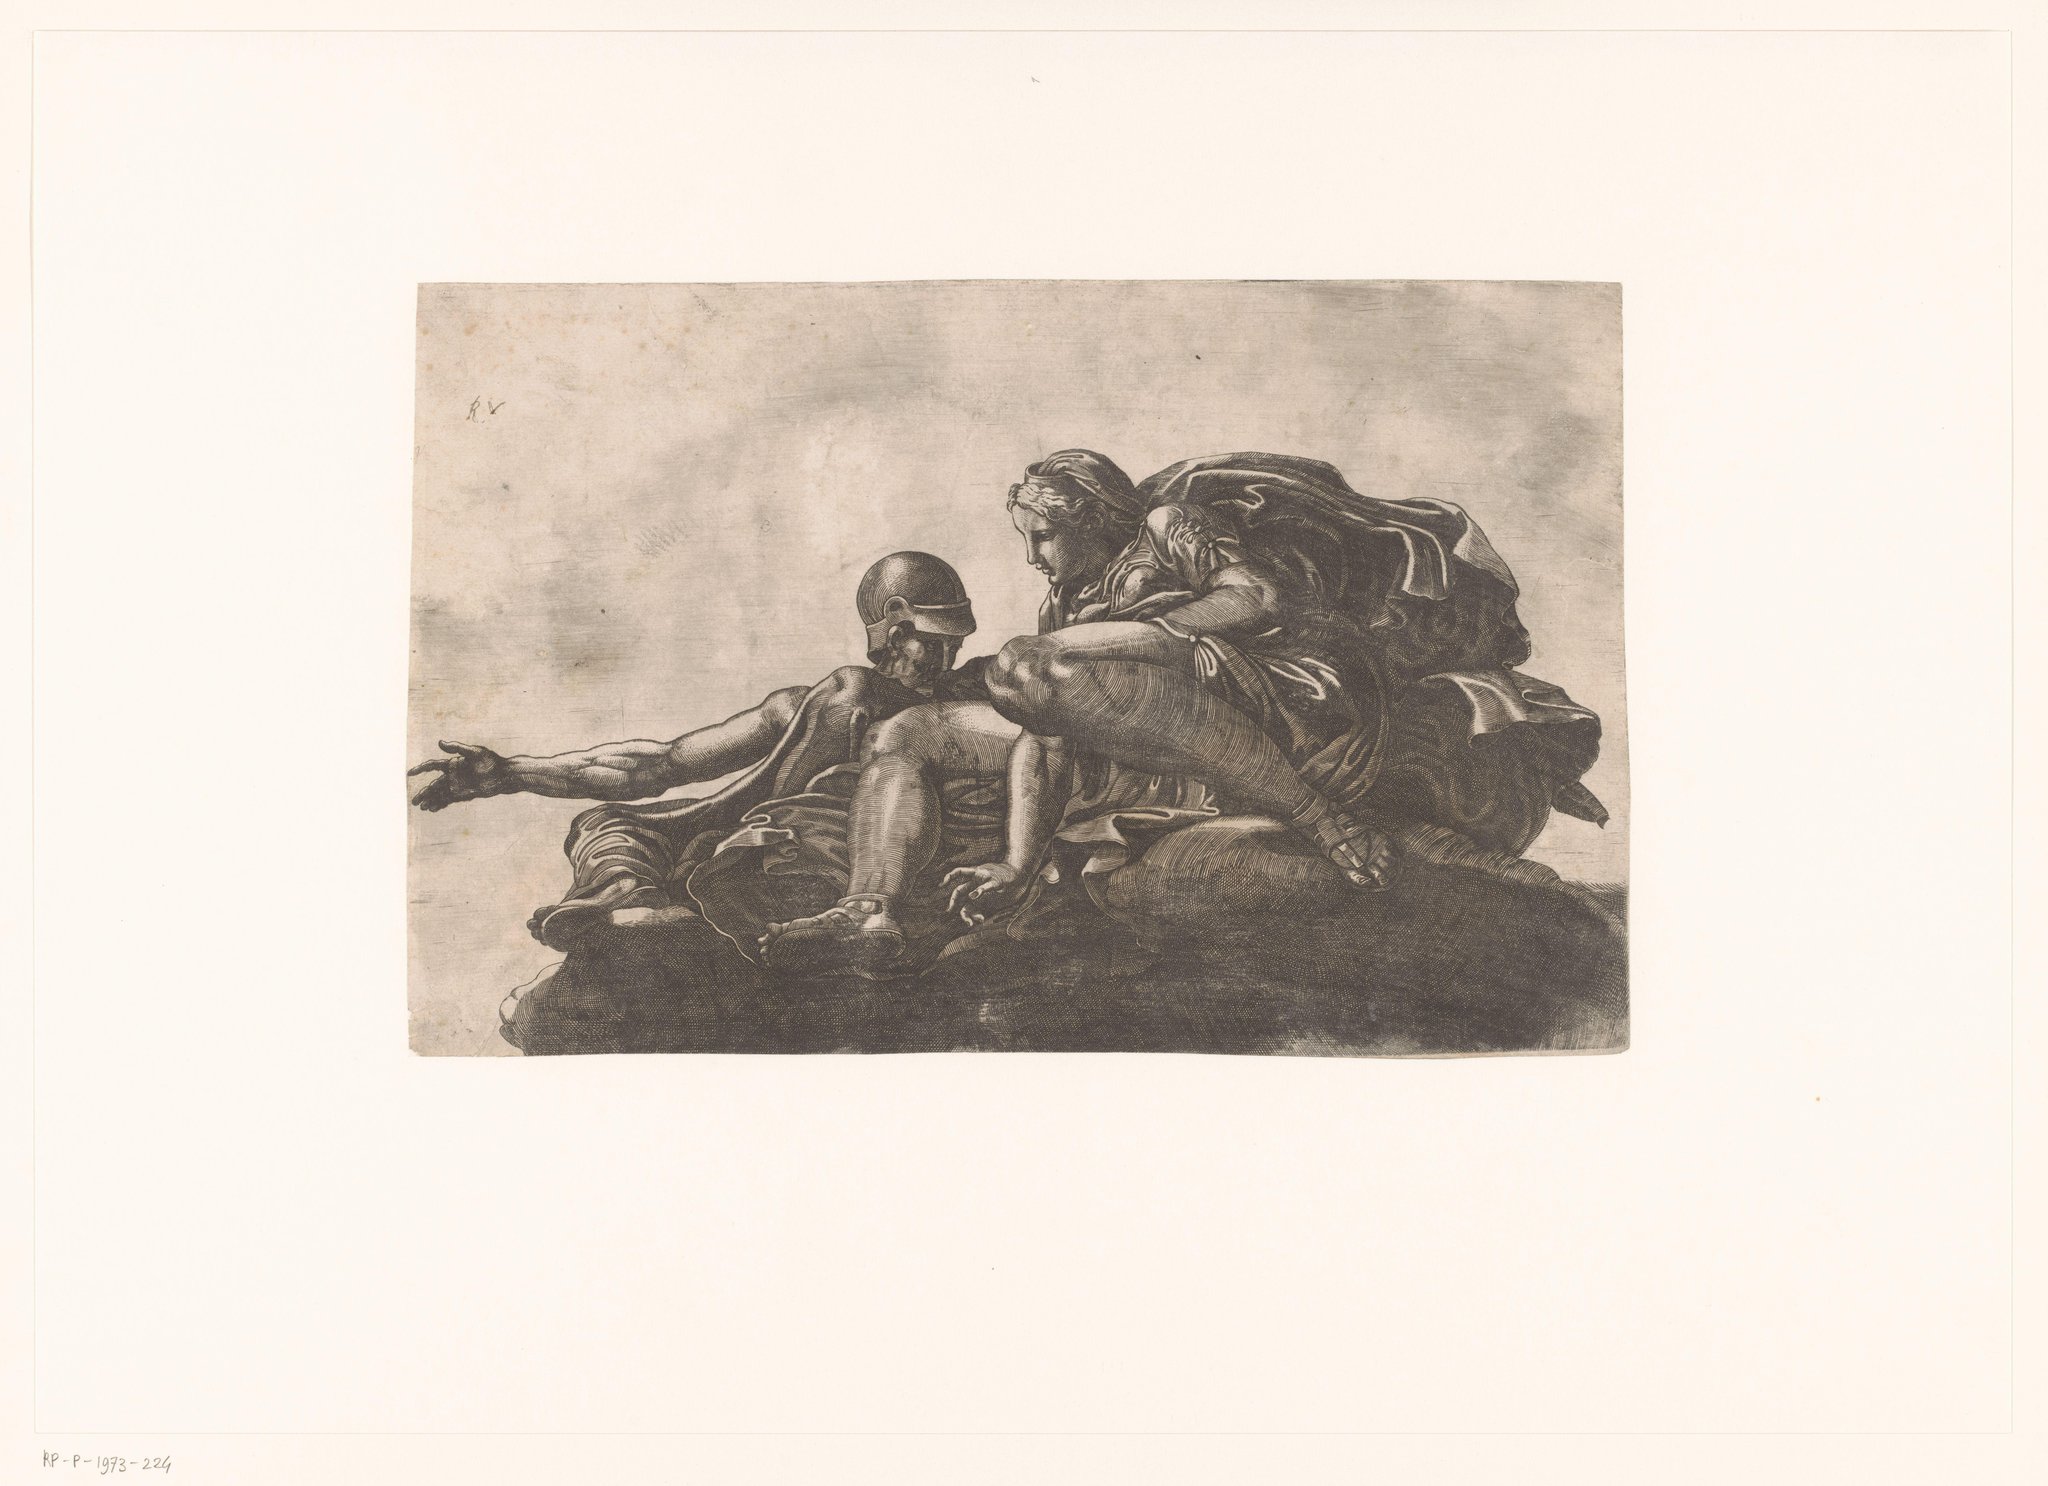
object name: print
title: Mars en Venus op een wolk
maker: francesco primaticcio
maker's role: draughtsman, painter, sculptor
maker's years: 1504-1570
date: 1600-1699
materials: paper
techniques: engraving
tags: mars and venus as lovers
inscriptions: collector's mark: Lugt 2228, collector's mark: Lugt 2760, inscription: ‘R.V.’